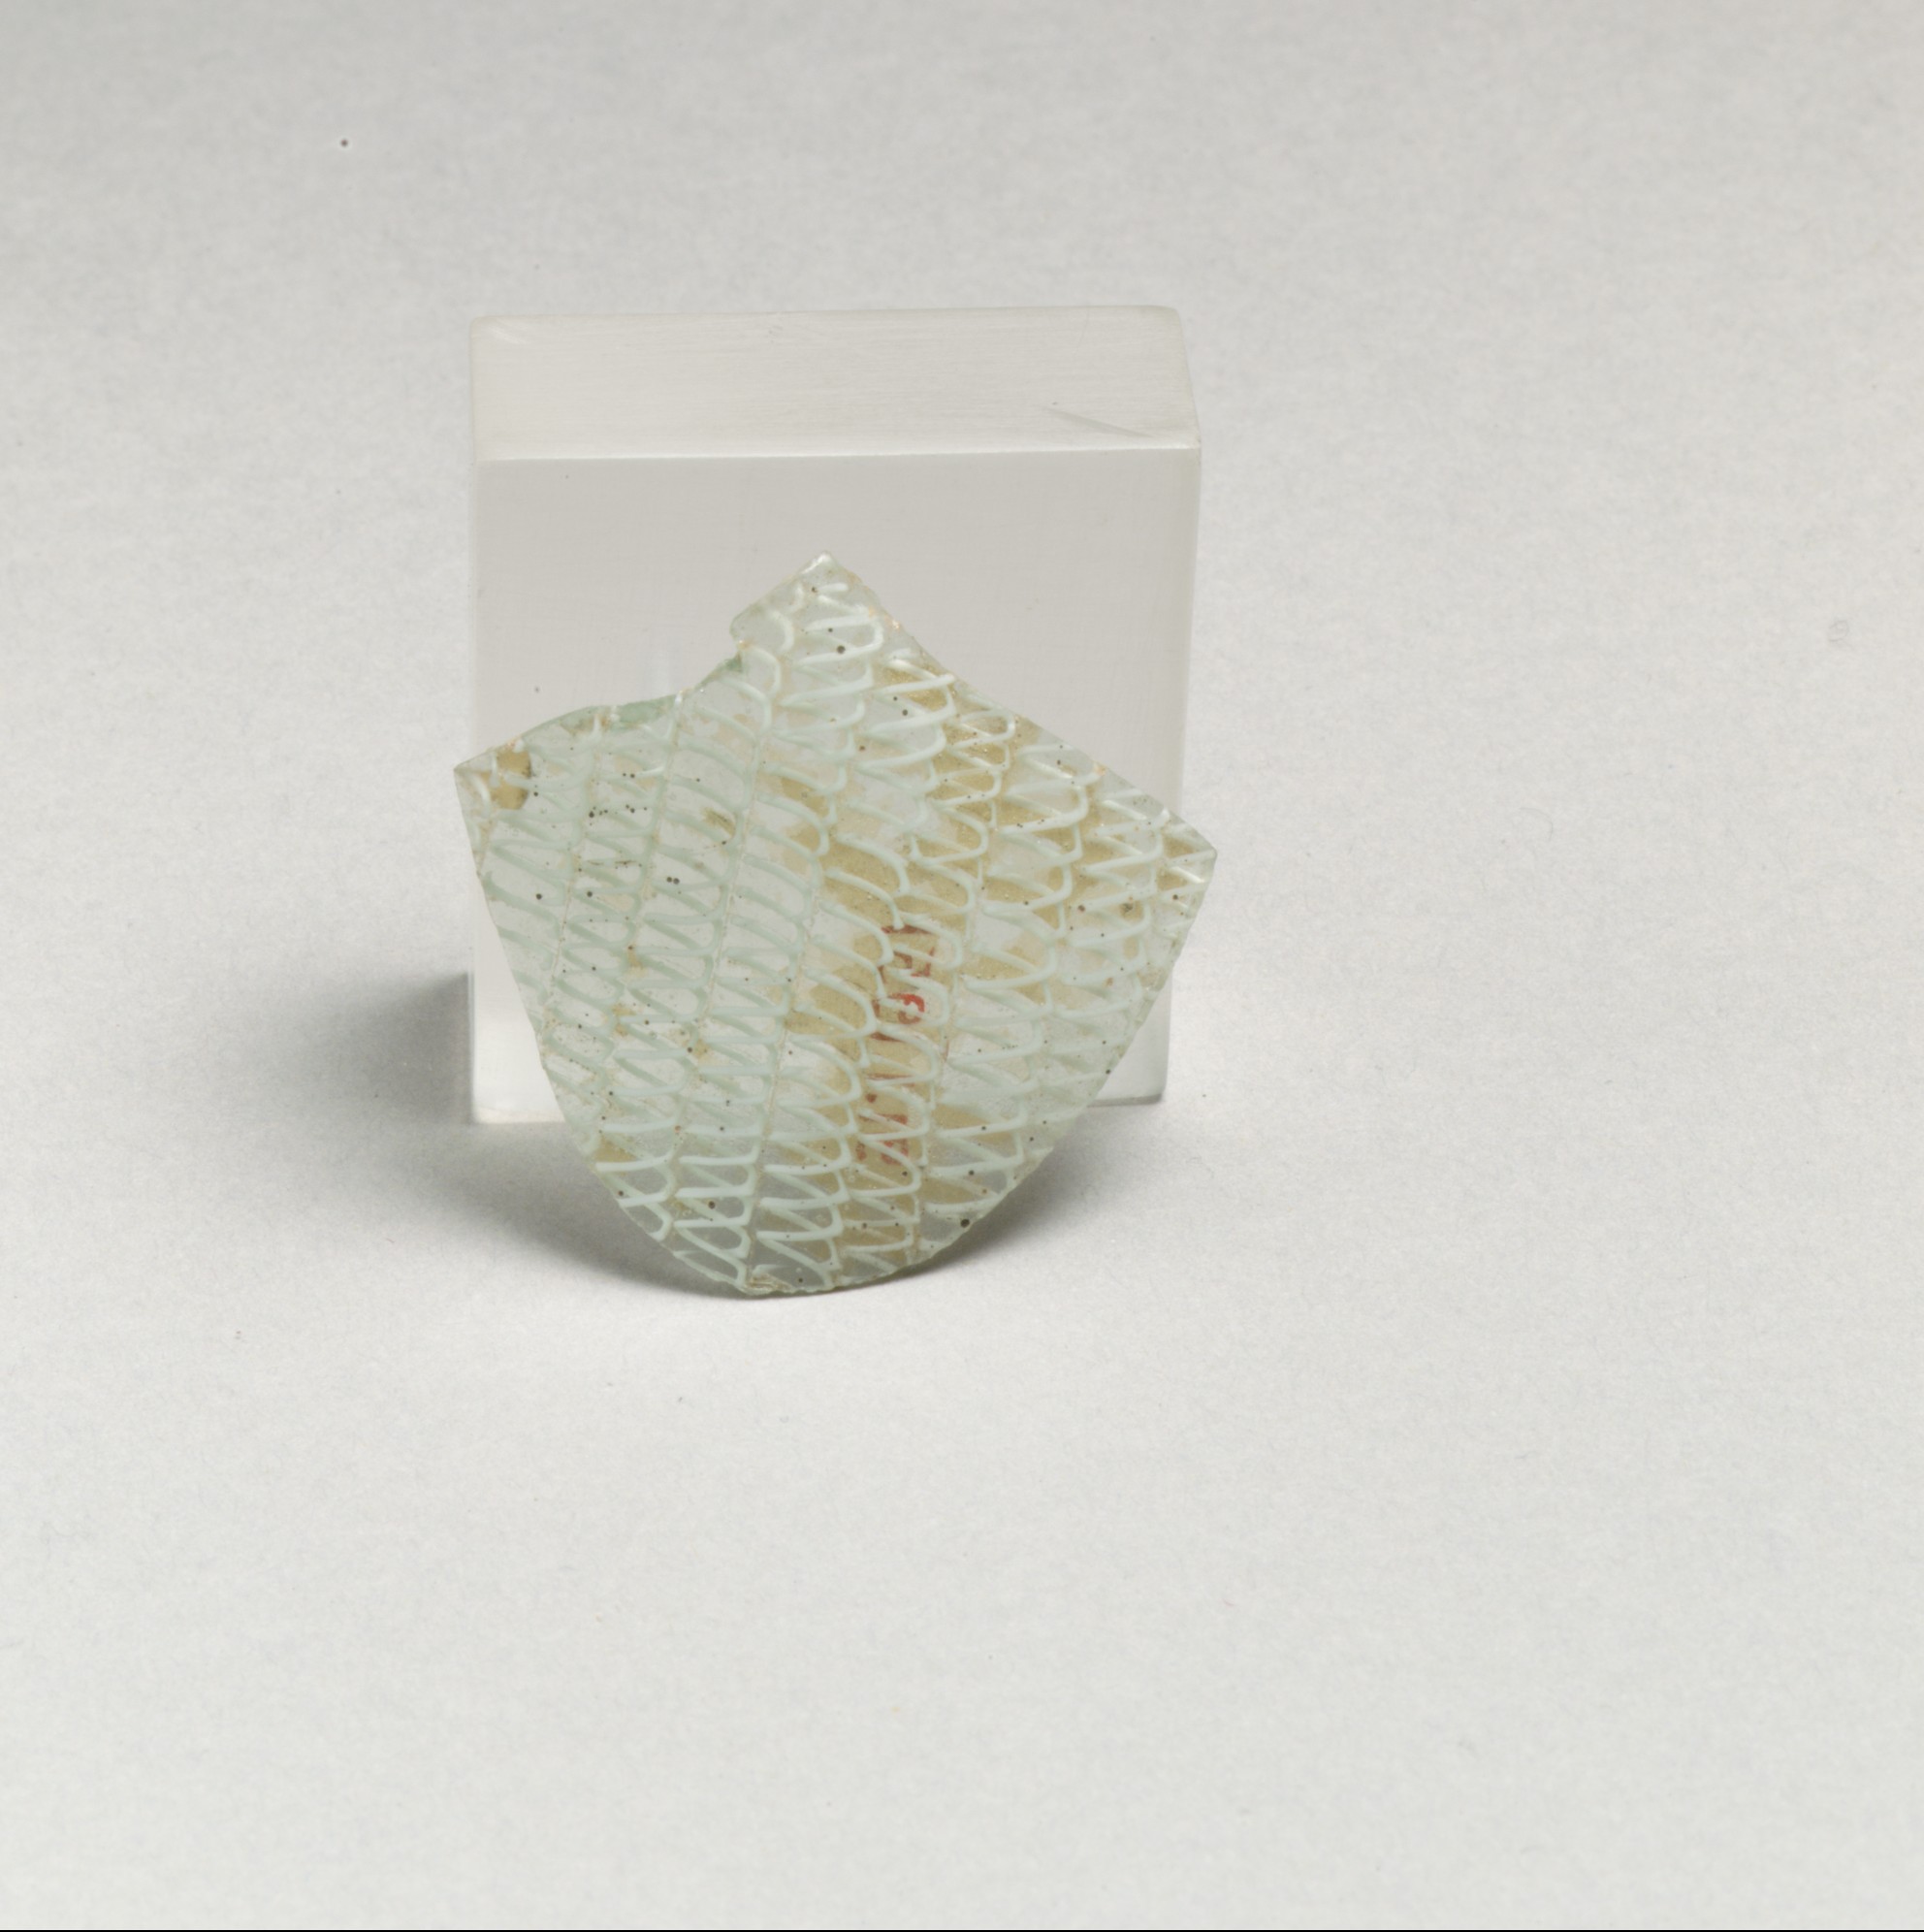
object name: fragment, network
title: Glass network mosaic fragment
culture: roman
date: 34 BCE-33 CE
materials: glass